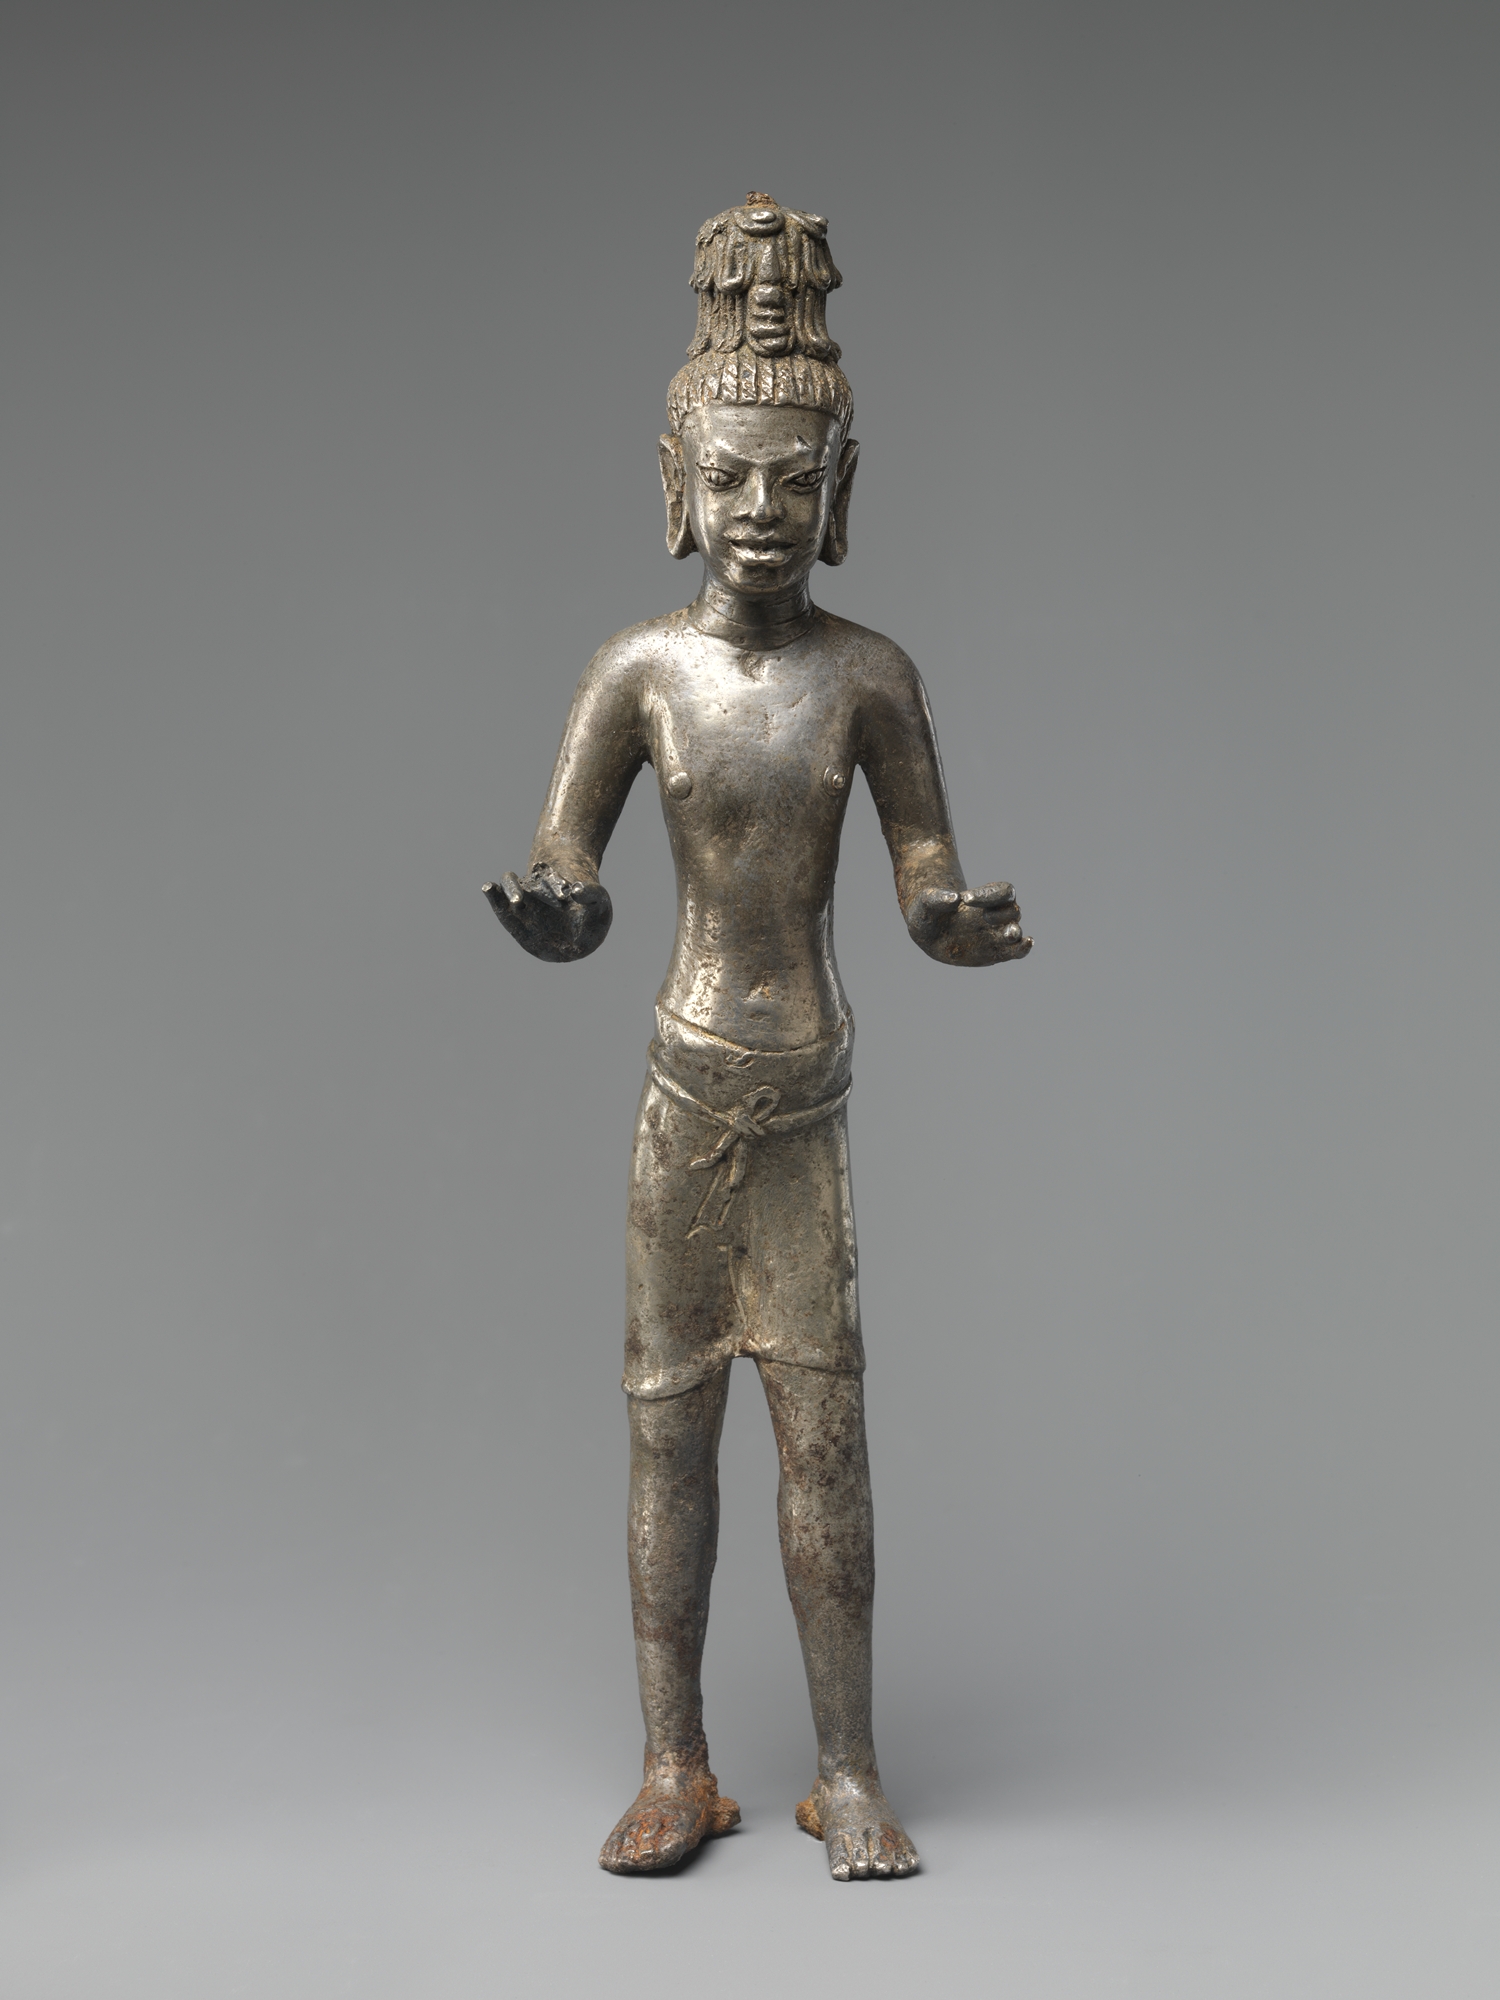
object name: figure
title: Standing Bodhisattva Maitreya, the Buddha of the Future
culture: northeast thai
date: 701-800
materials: alloy, bronze, silver, tin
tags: buddhism,bodhisattvas,maitreya